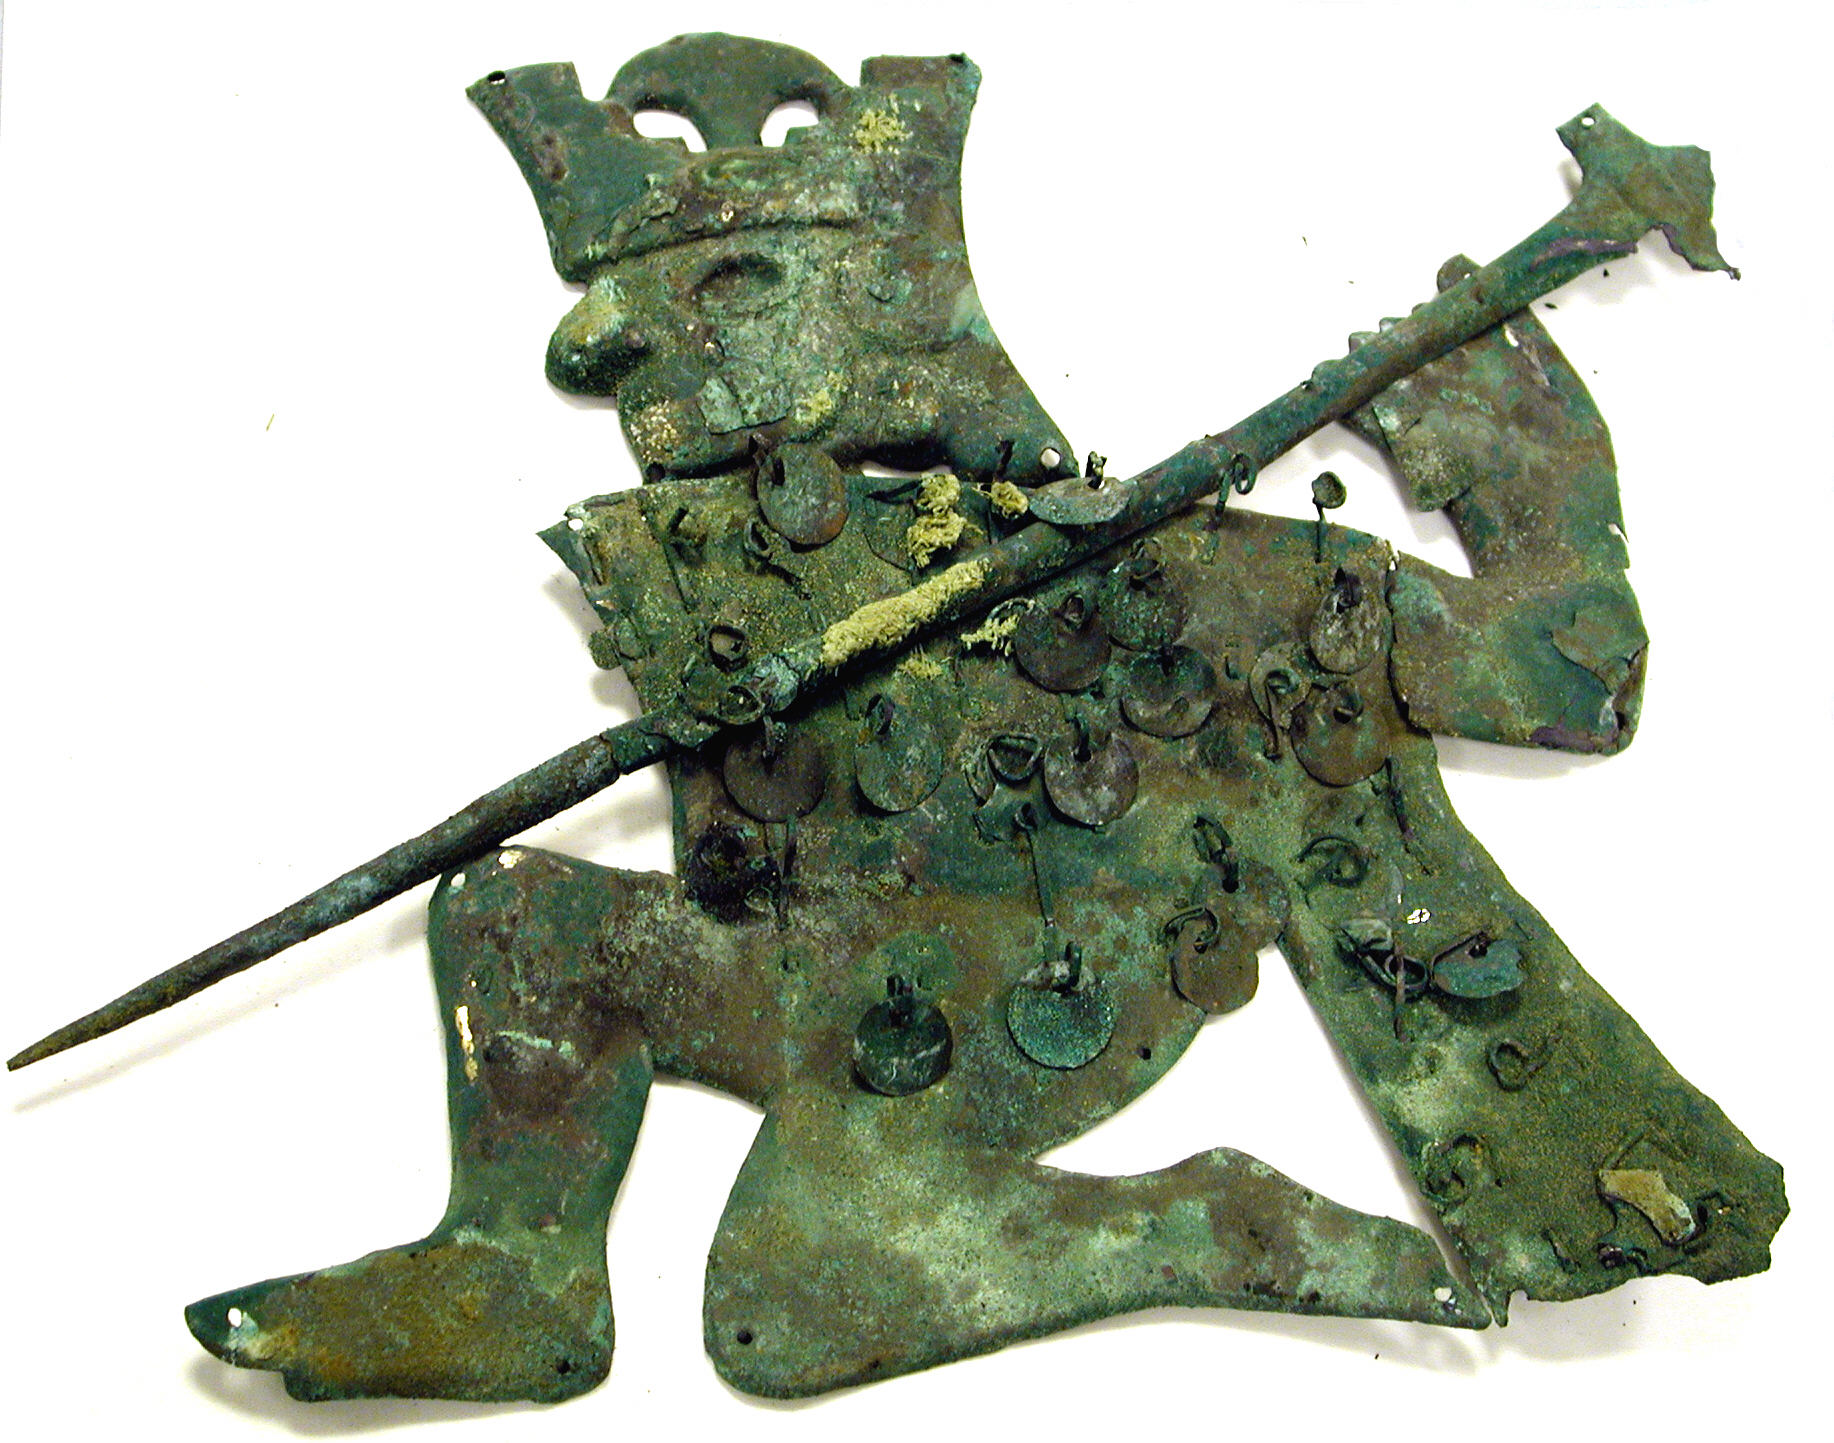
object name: ornament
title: Profile Warrior Ornament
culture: moche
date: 501-700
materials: metal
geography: peru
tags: warriors